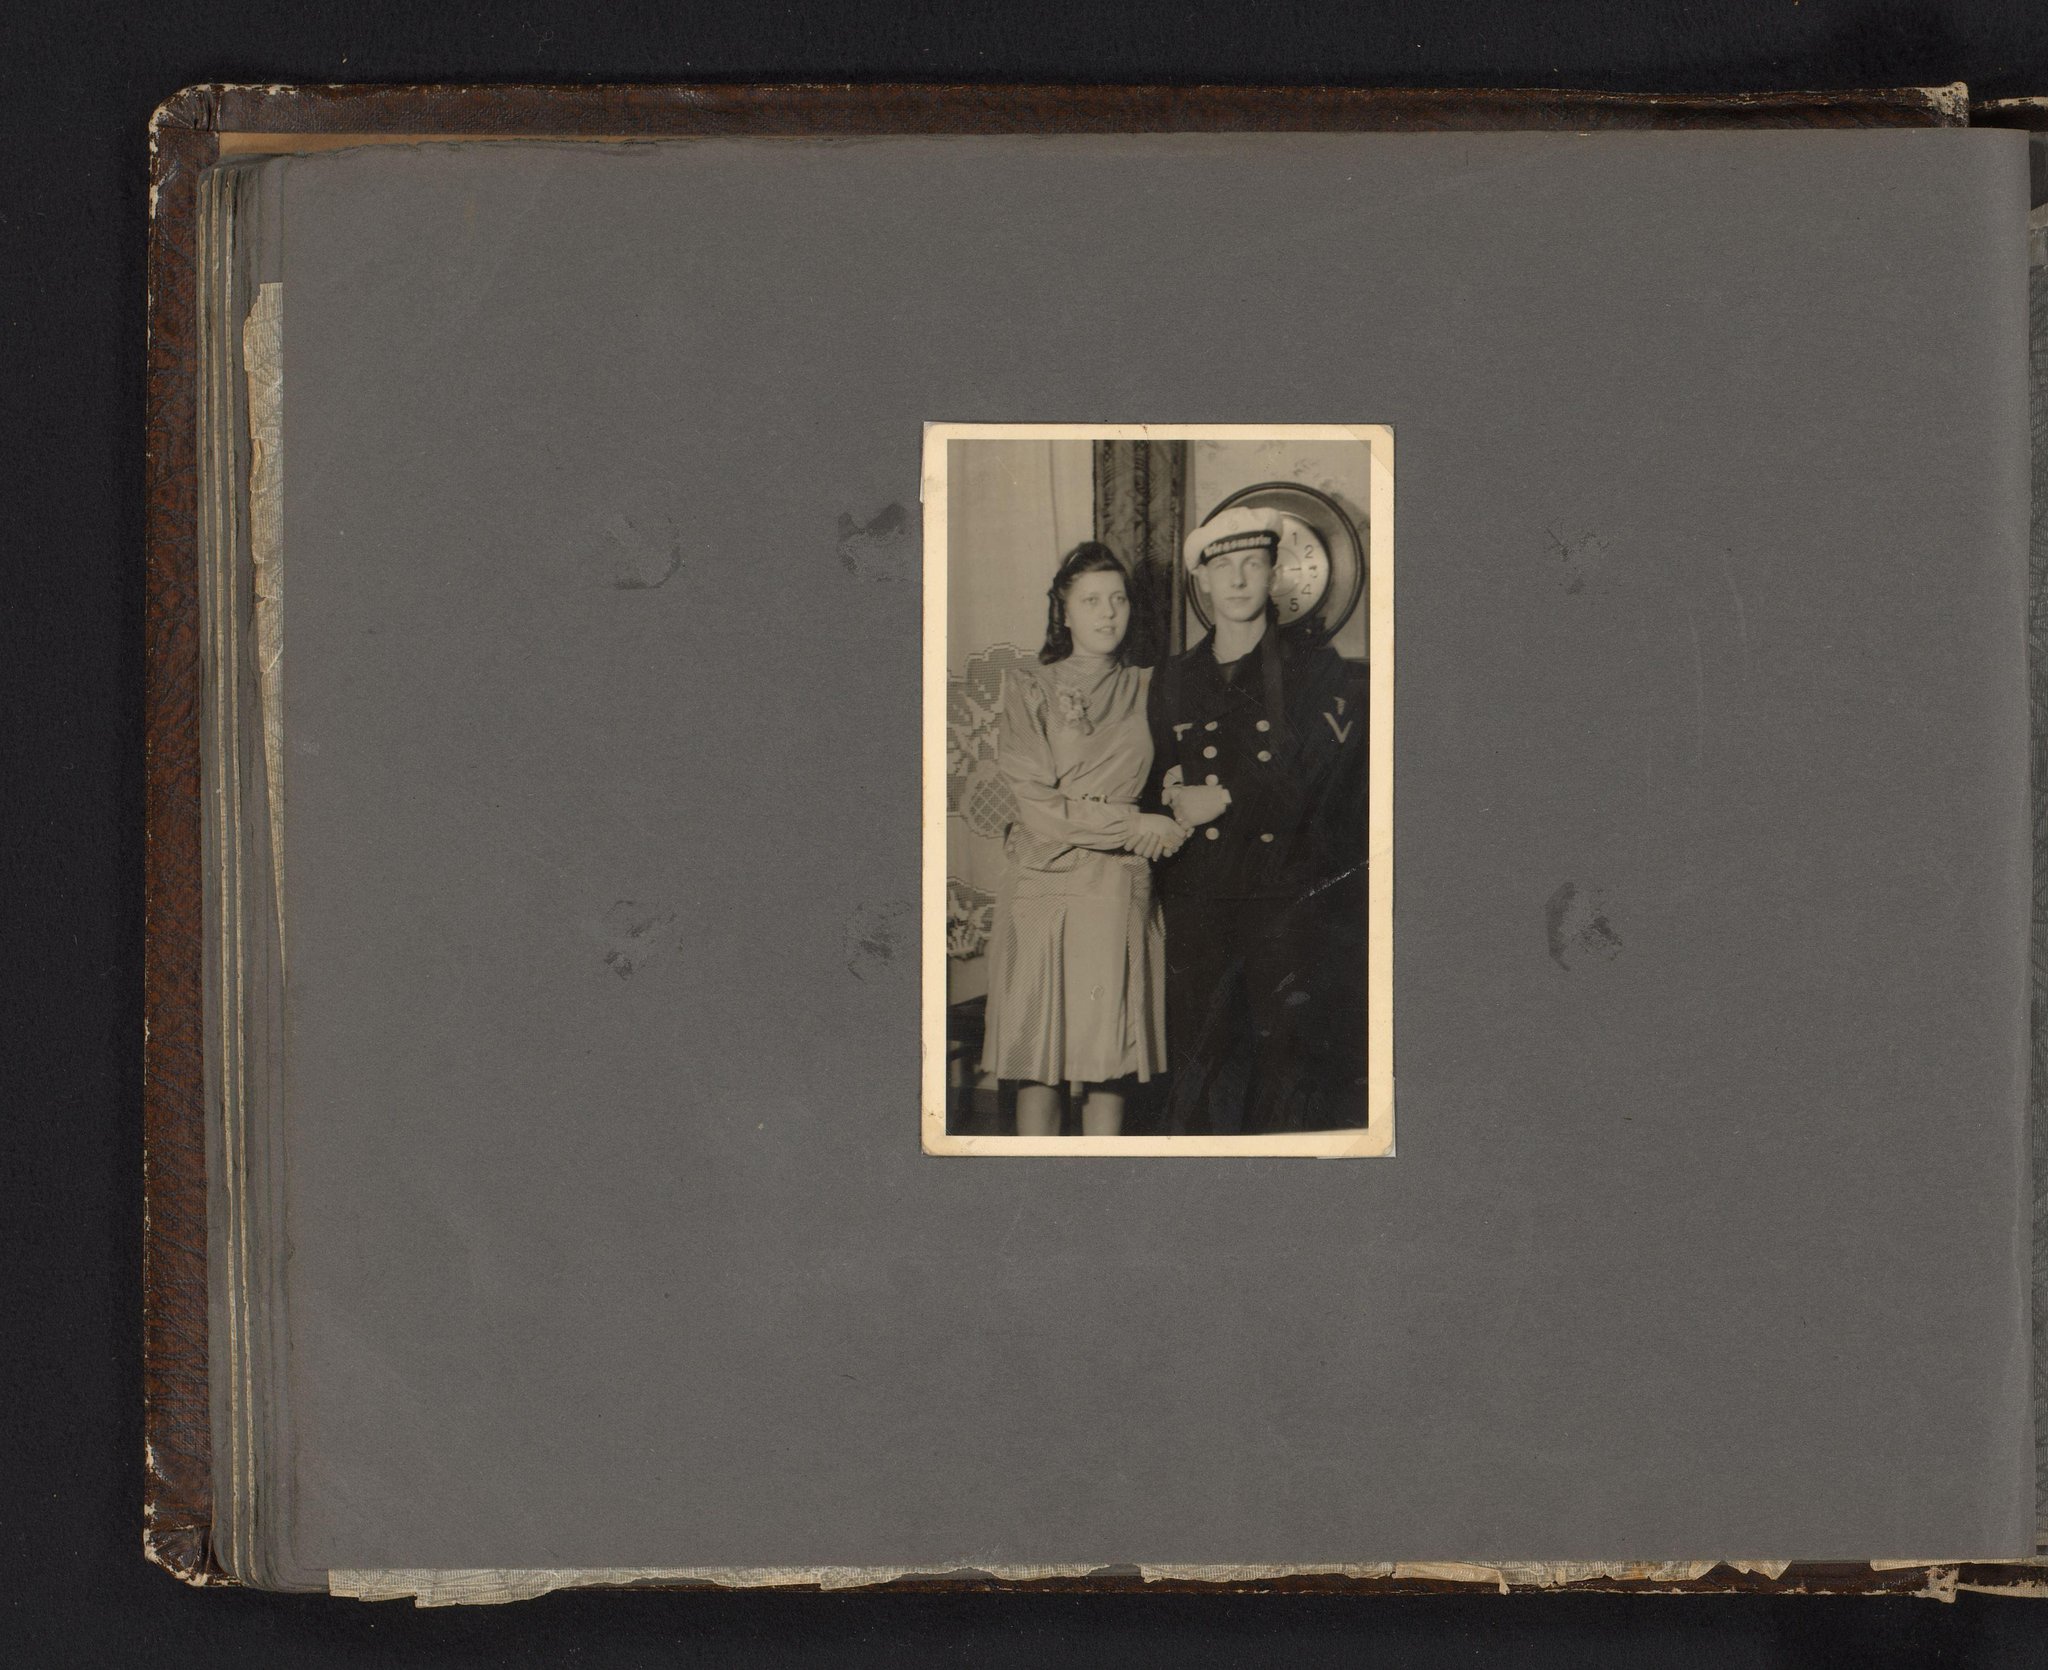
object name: album leaf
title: Verloofde vrienden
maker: Anonymous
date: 1909-1942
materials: paper, photographic support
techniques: gelatin silver print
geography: berlin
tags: the company, the unit, the troop ~ military service, sailor, betrothal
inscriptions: date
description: Albumblad met een foto van een verloofd paar, Hildegard Schwanke en de matroos Felix Kurze, Berlijn september 1942. Onderdeel van het fotoalbum Kriegsmarine.